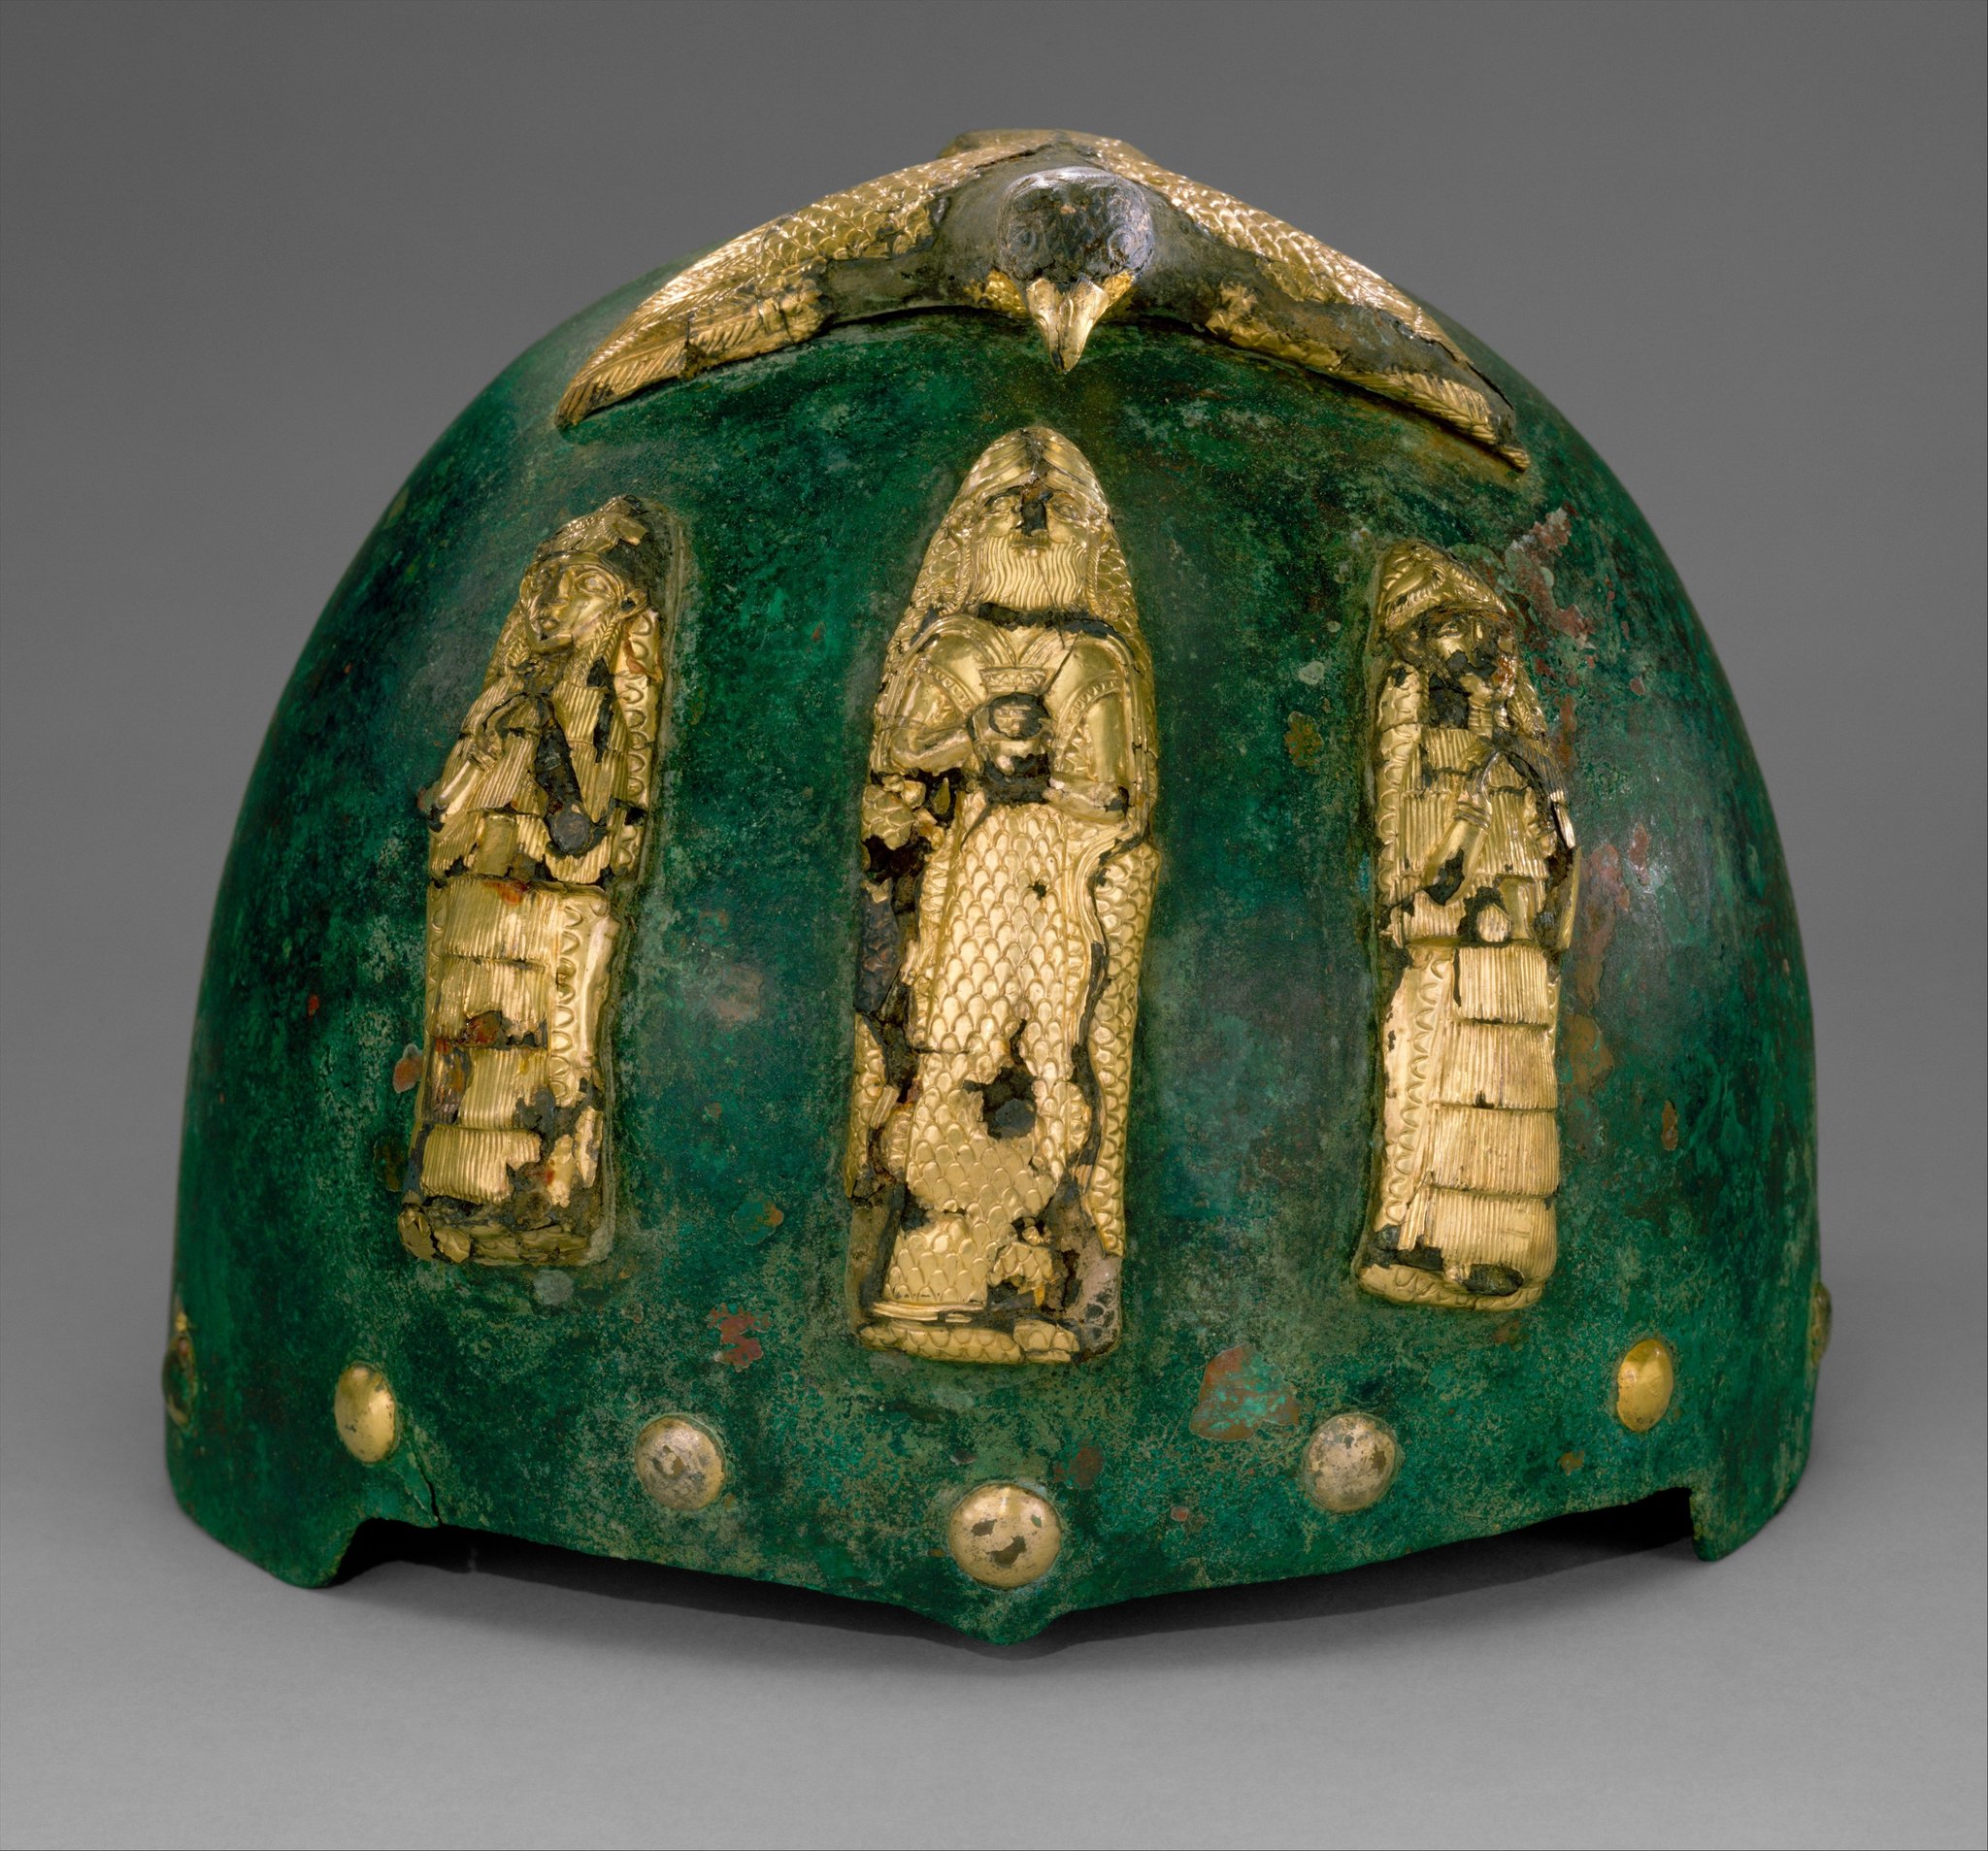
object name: helmet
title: Helmet with divine figures beneath a bird with outstretched wings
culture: elamite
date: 1500-1100 BCE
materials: bronze, gold foil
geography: iran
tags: birds,men,women,deities